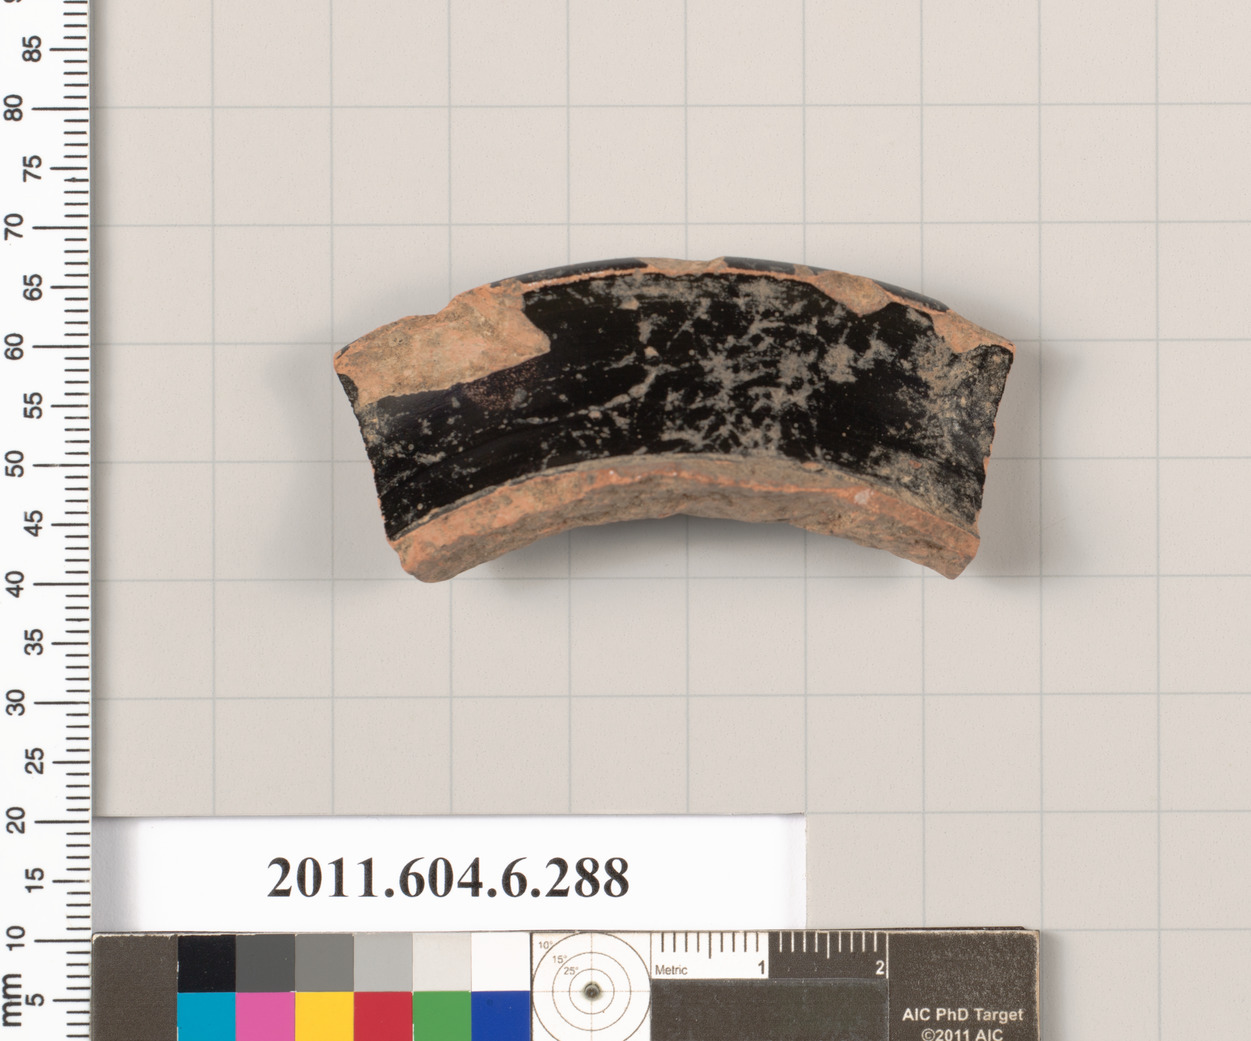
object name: kalathos fragment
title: Terracotta rim fragment of a kalathos?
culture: greek, attic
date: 534-468 BCE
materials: terracotta